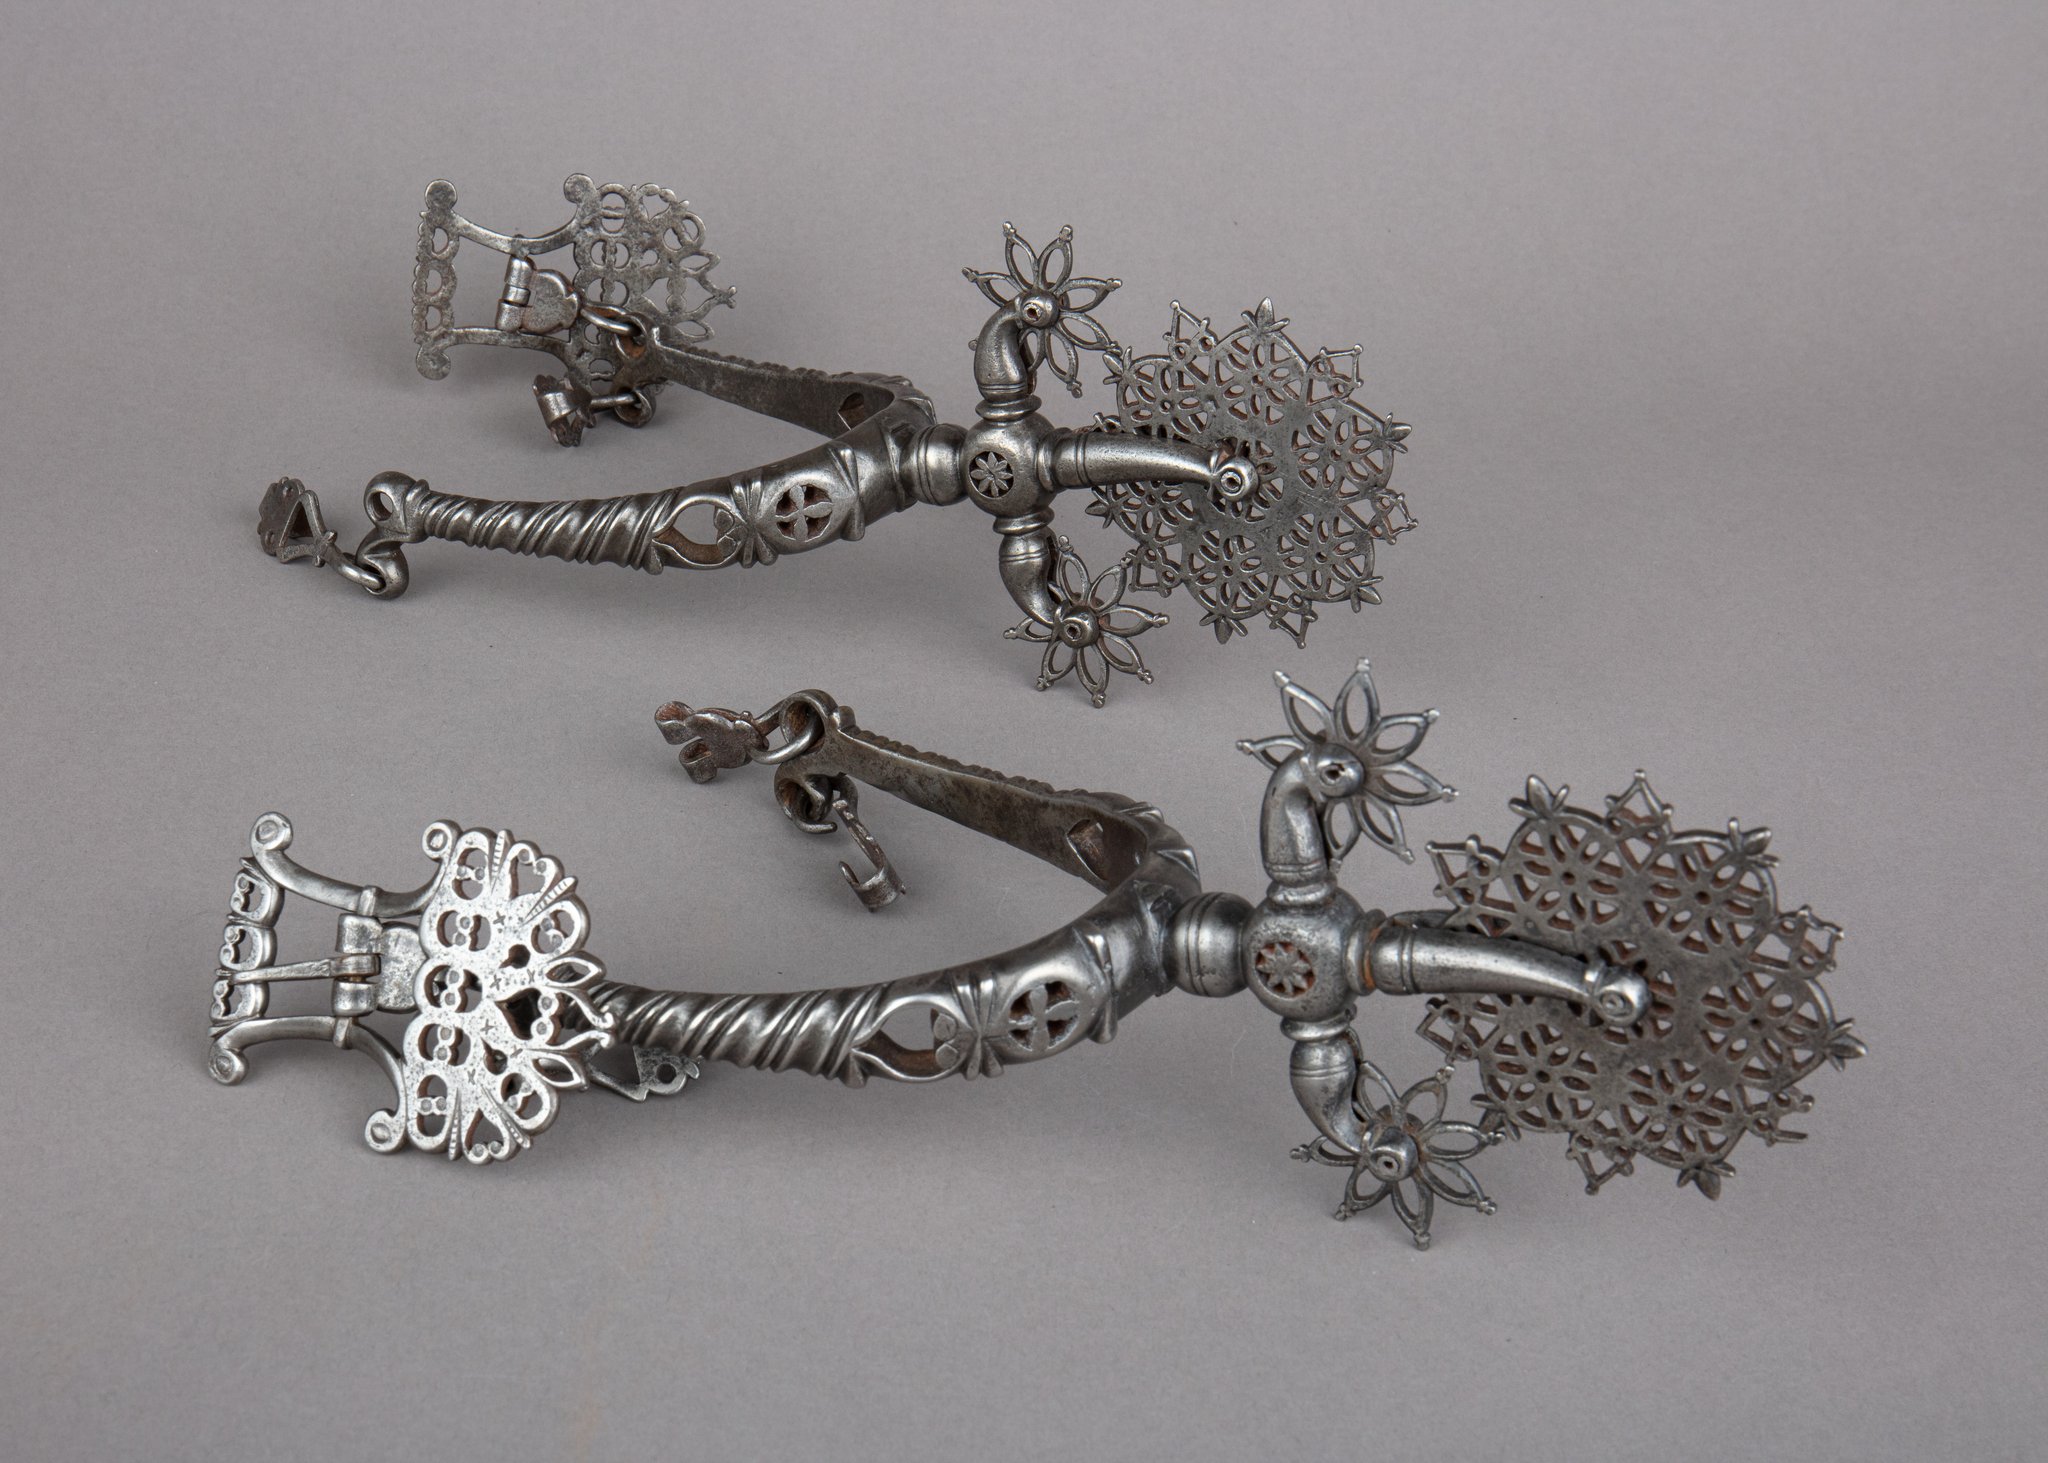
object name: spur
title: Pair of Rowel Spurs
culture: spanish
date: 1601-1700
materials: metal alloy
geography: spain